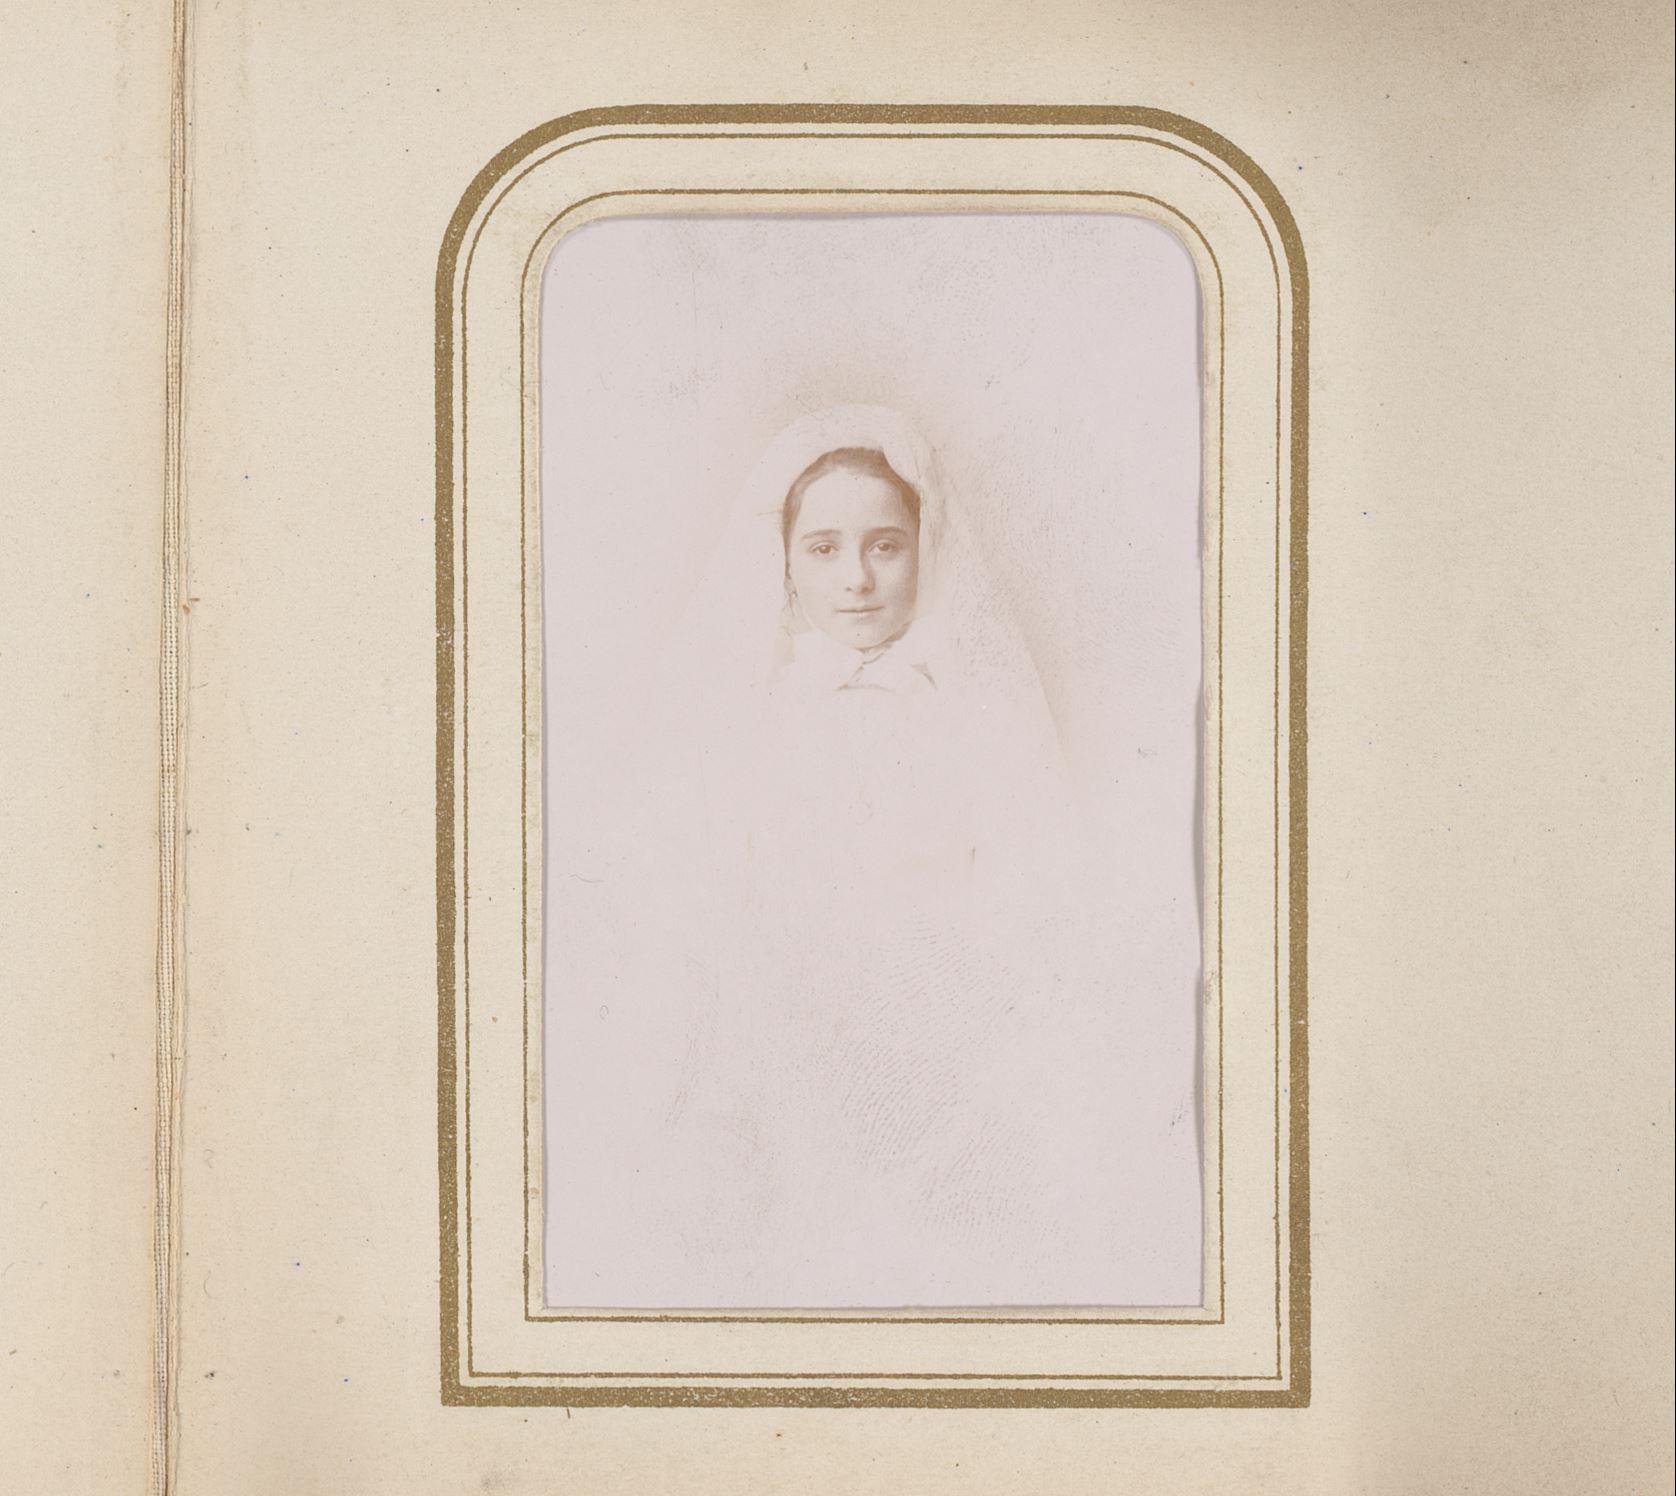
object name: album leaf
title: Portret van een meisje met sluier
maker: pichois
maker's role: fotograaf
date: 1880-1920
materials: cardboard, photographic support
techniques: collodion silver print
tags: historical persons, girl (child between toddler and youth)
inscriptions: inscription: ‘Phototgraphie/ Duphot/ Pichois/ 9 Rue Duphot/ Paris (...)’